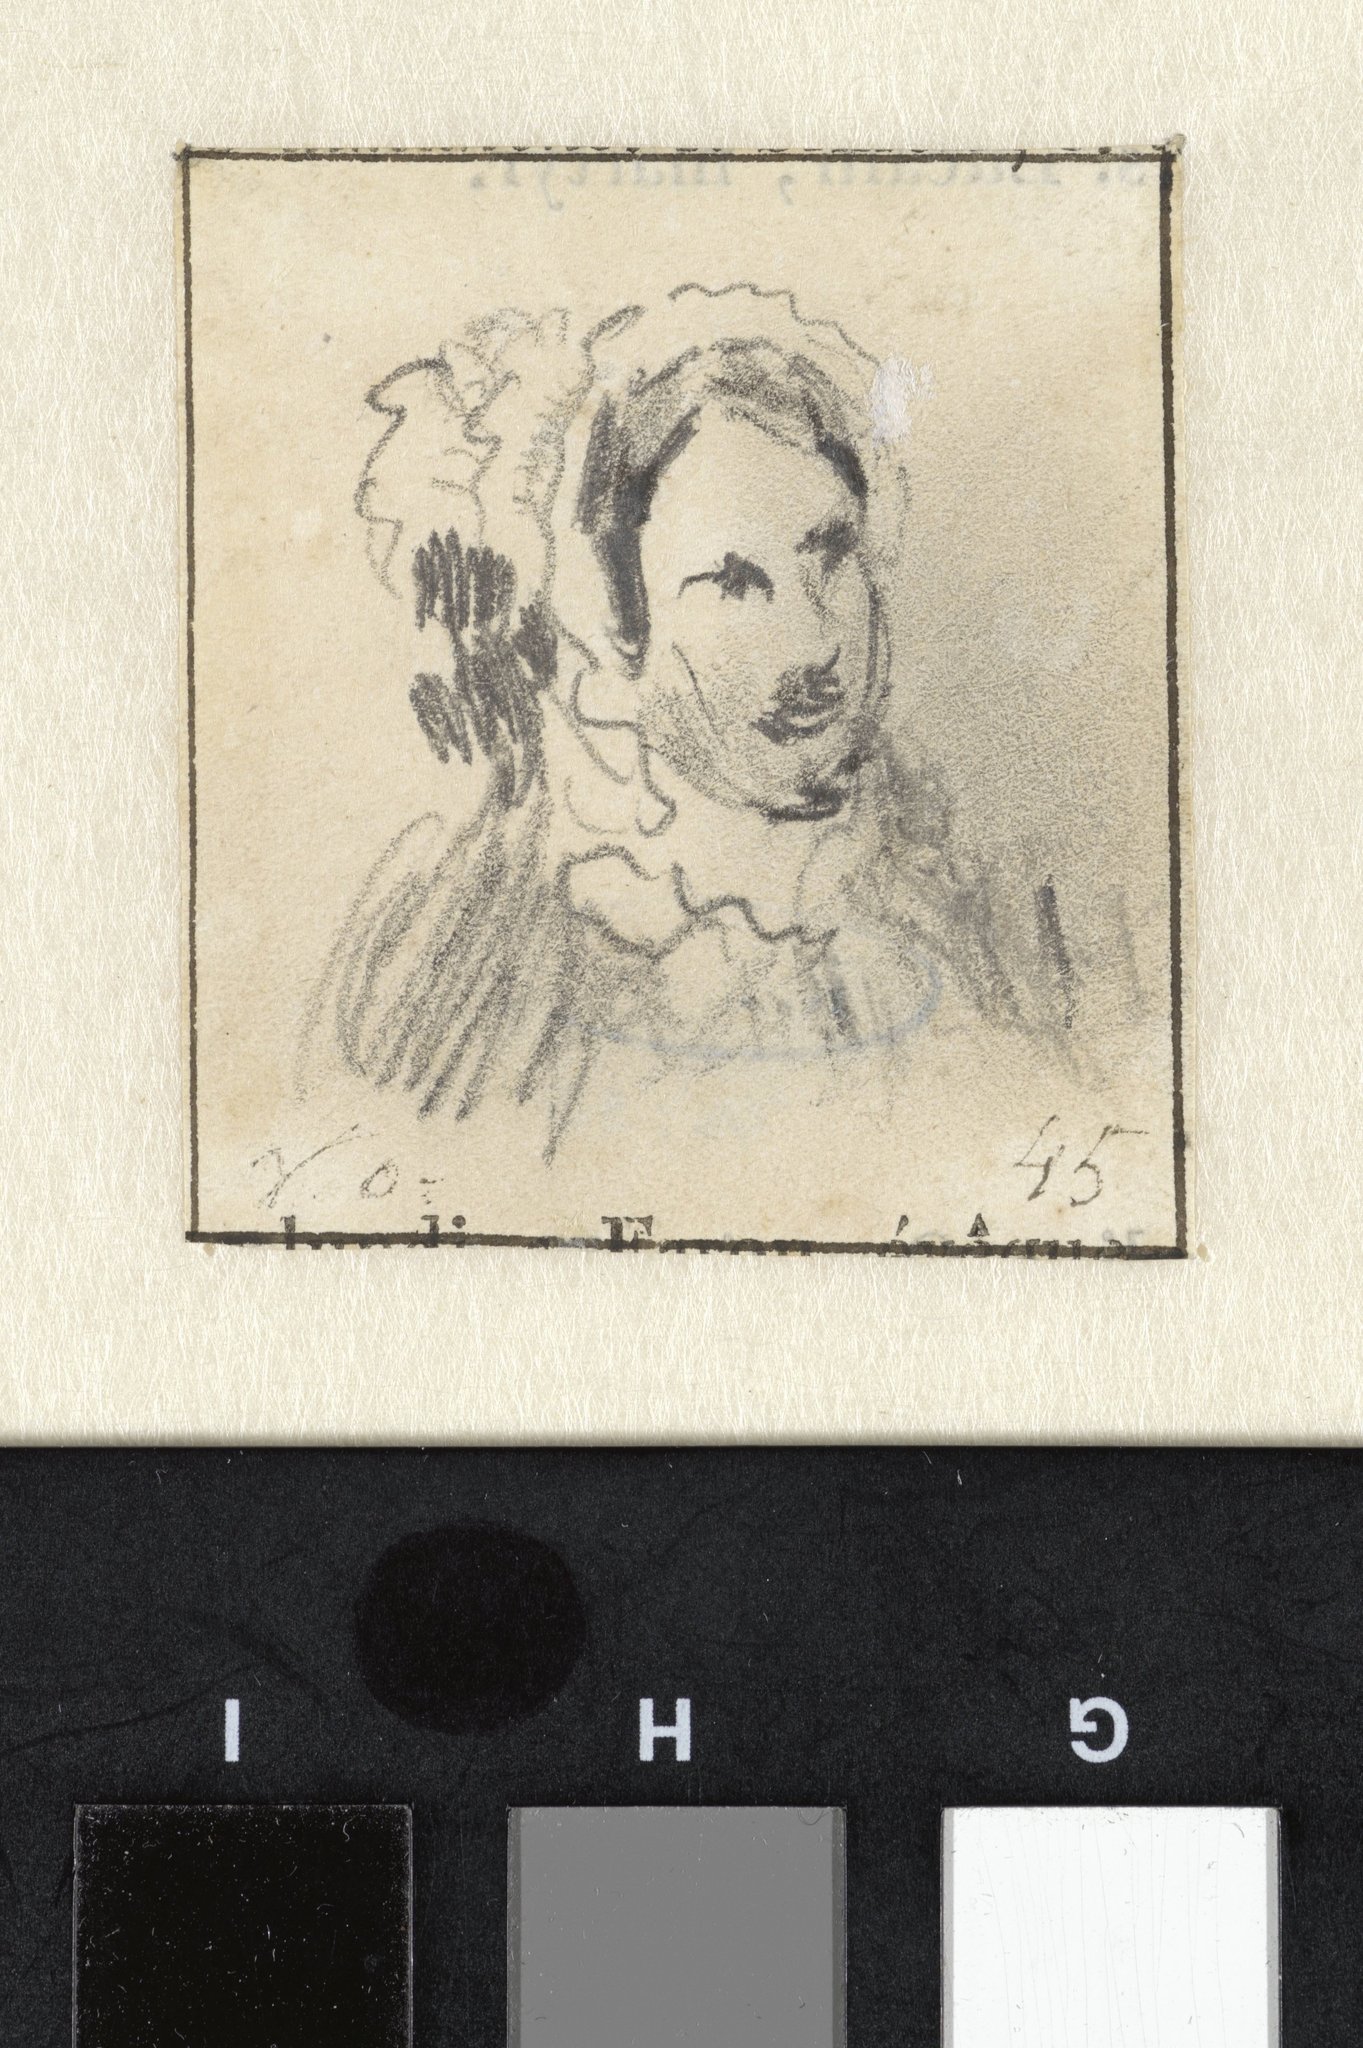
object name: drawing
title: Studie van een vrouw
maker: georgius jacobus johannes van os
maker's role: draughtsman, painter, print maker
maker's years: 1782-1861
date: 1845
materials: paper, pencil